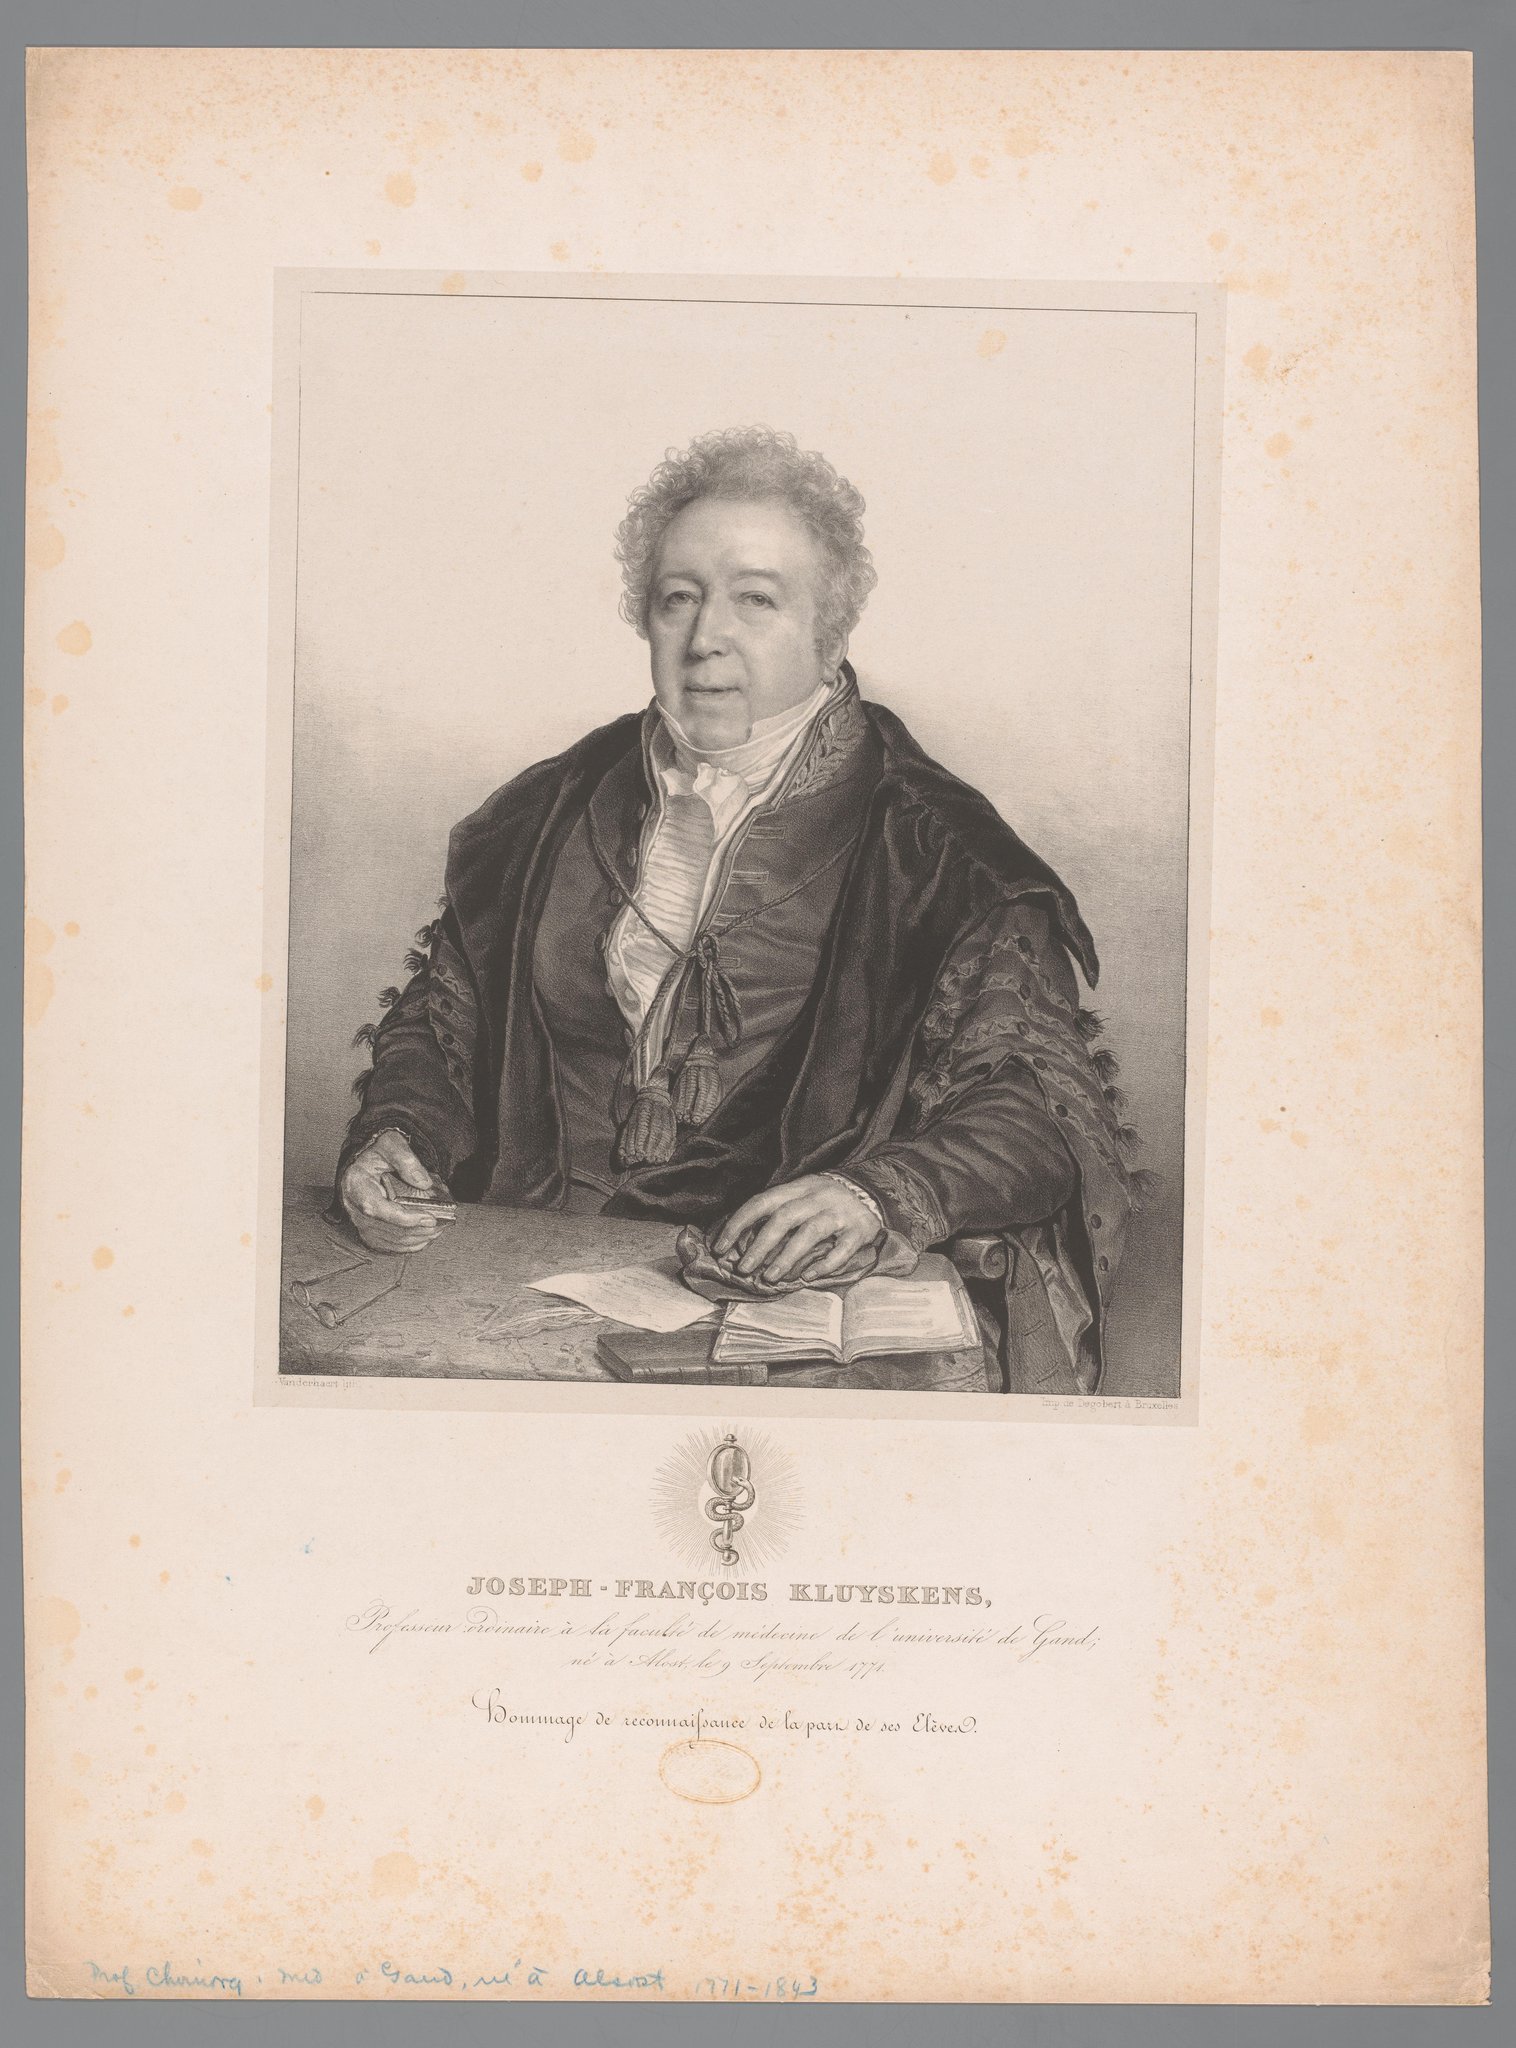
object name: print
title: Portret van Joseph Francois Kluyskens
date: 1800-1846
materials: paper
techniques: lithograph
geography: brussels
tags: adult man, historical persons, book - mm - book open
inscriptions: collector's mark: Lugt 2228, check stamp: ‘J. Pellizzaro Italien a Gand’, inscription: ‘v.S. 2981’